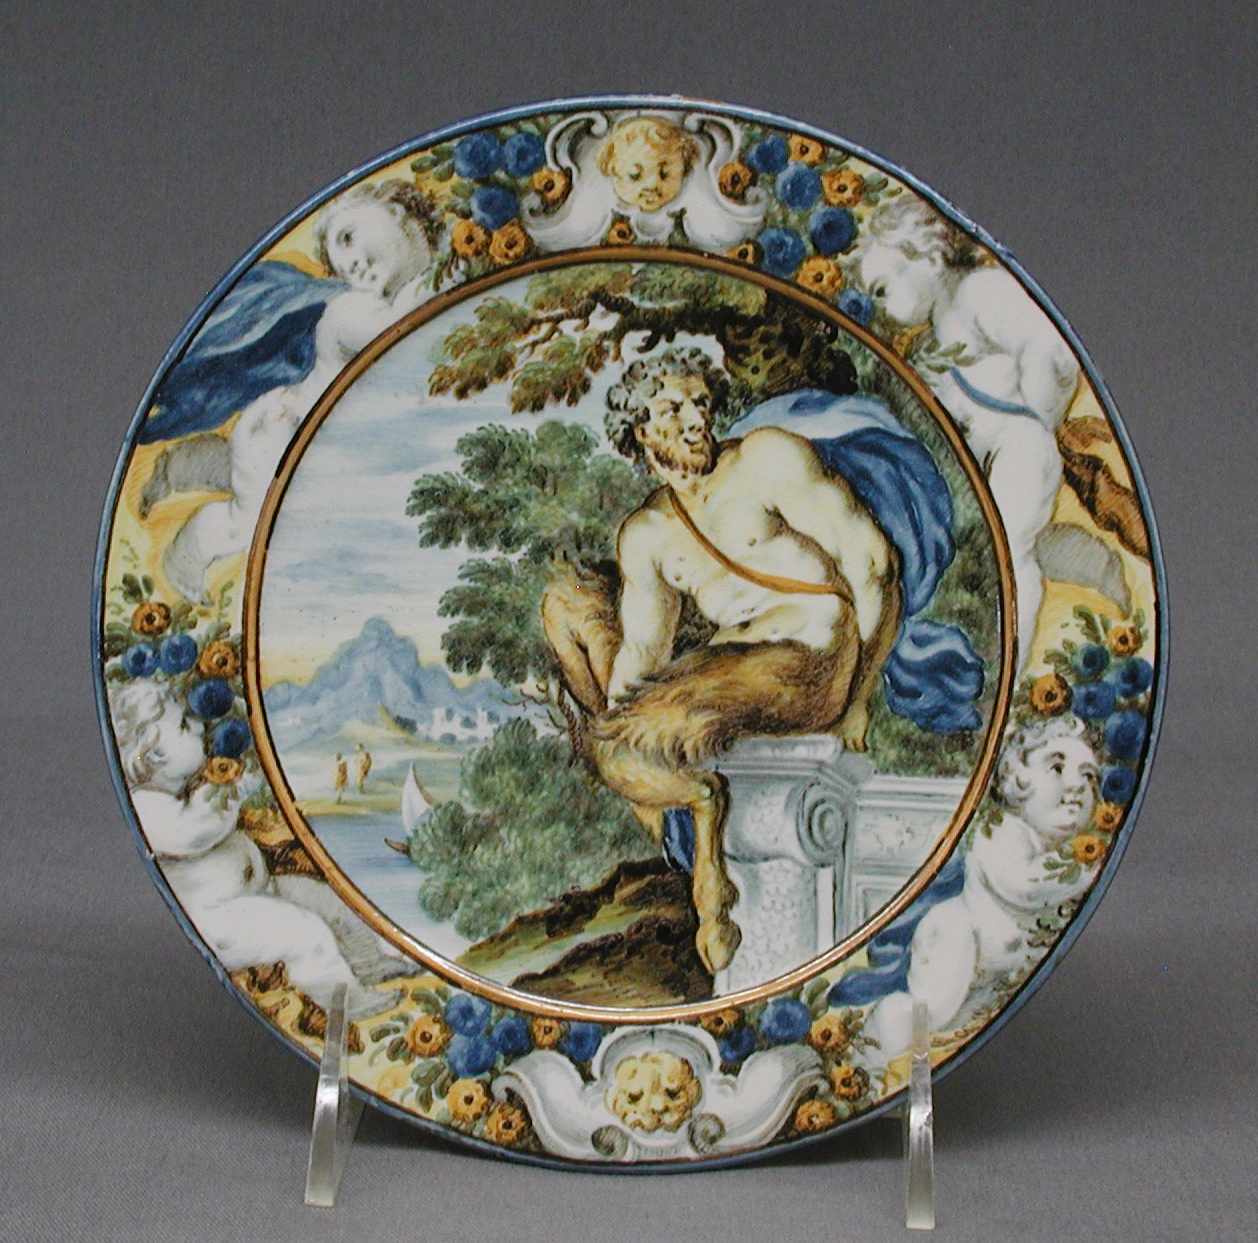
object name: plate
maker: castelli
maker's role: manufactory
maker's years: 1700-1900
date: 1701-1800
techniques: maiolica, glazing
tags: faces,infants,centaurs,trees